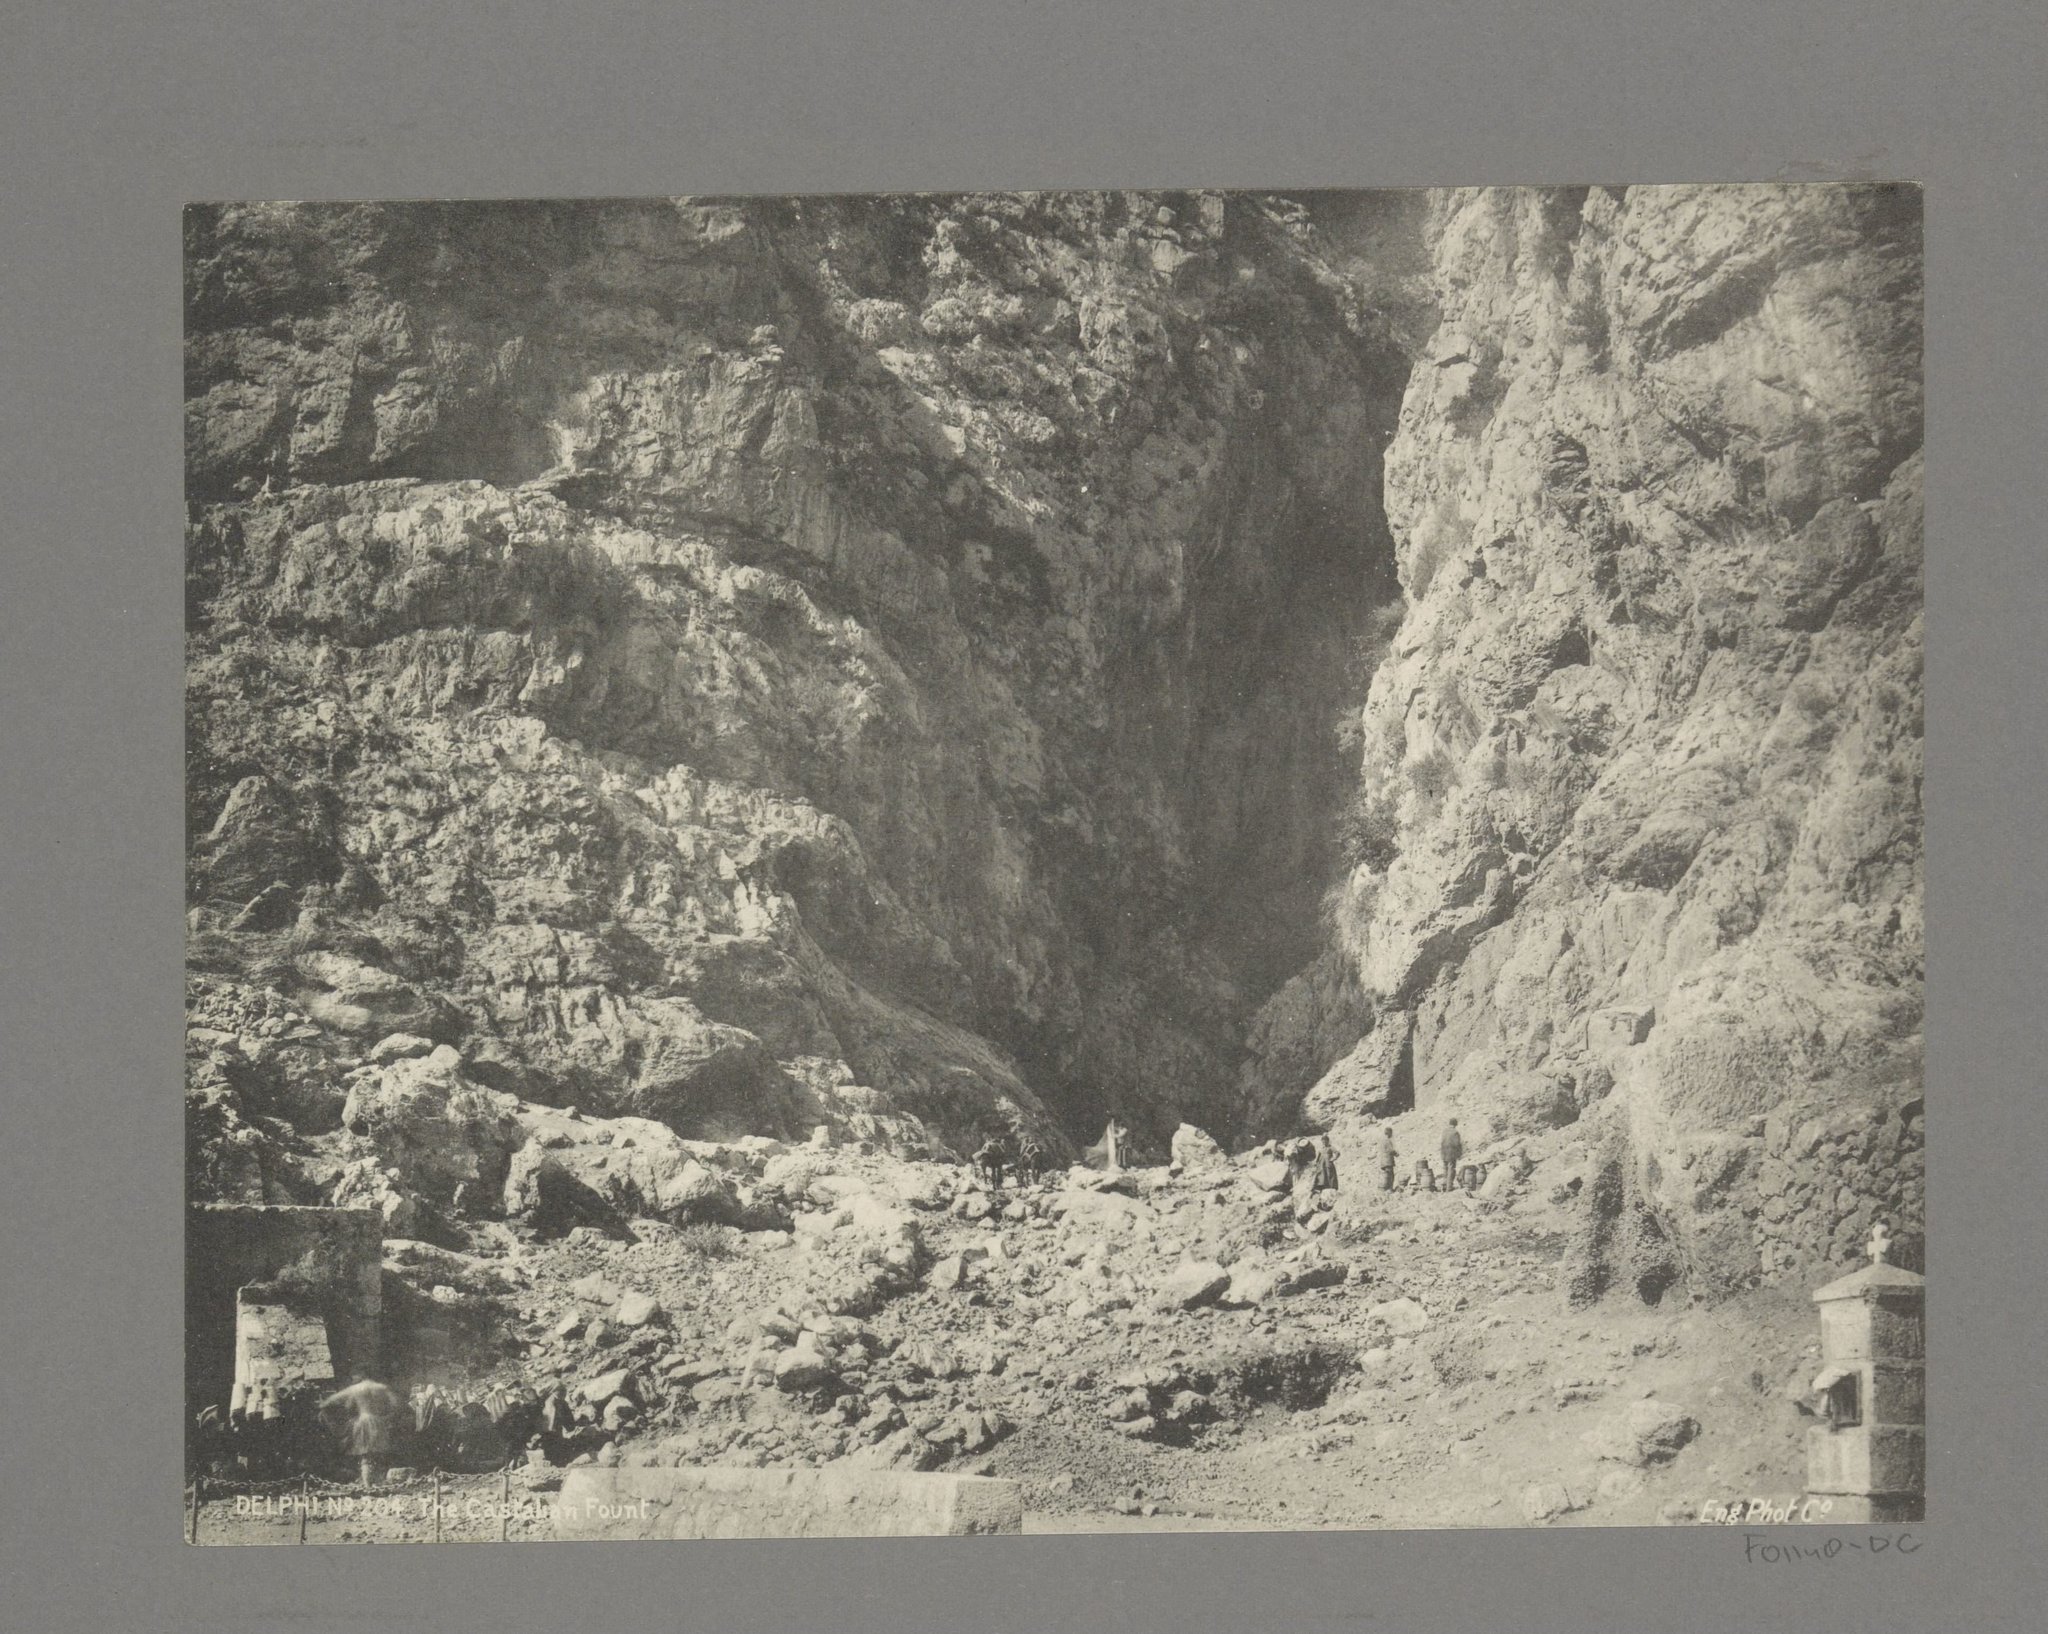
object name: album leaf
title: DELPHI the Castalian Fount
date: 1895-1905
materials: paper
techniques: photograph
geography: delphi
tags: well, rock-formations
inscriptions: number: ‘204’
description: Onderdeel van Reisalbum met foto's van bezienswaardigheden in Griekenland en Egypte.